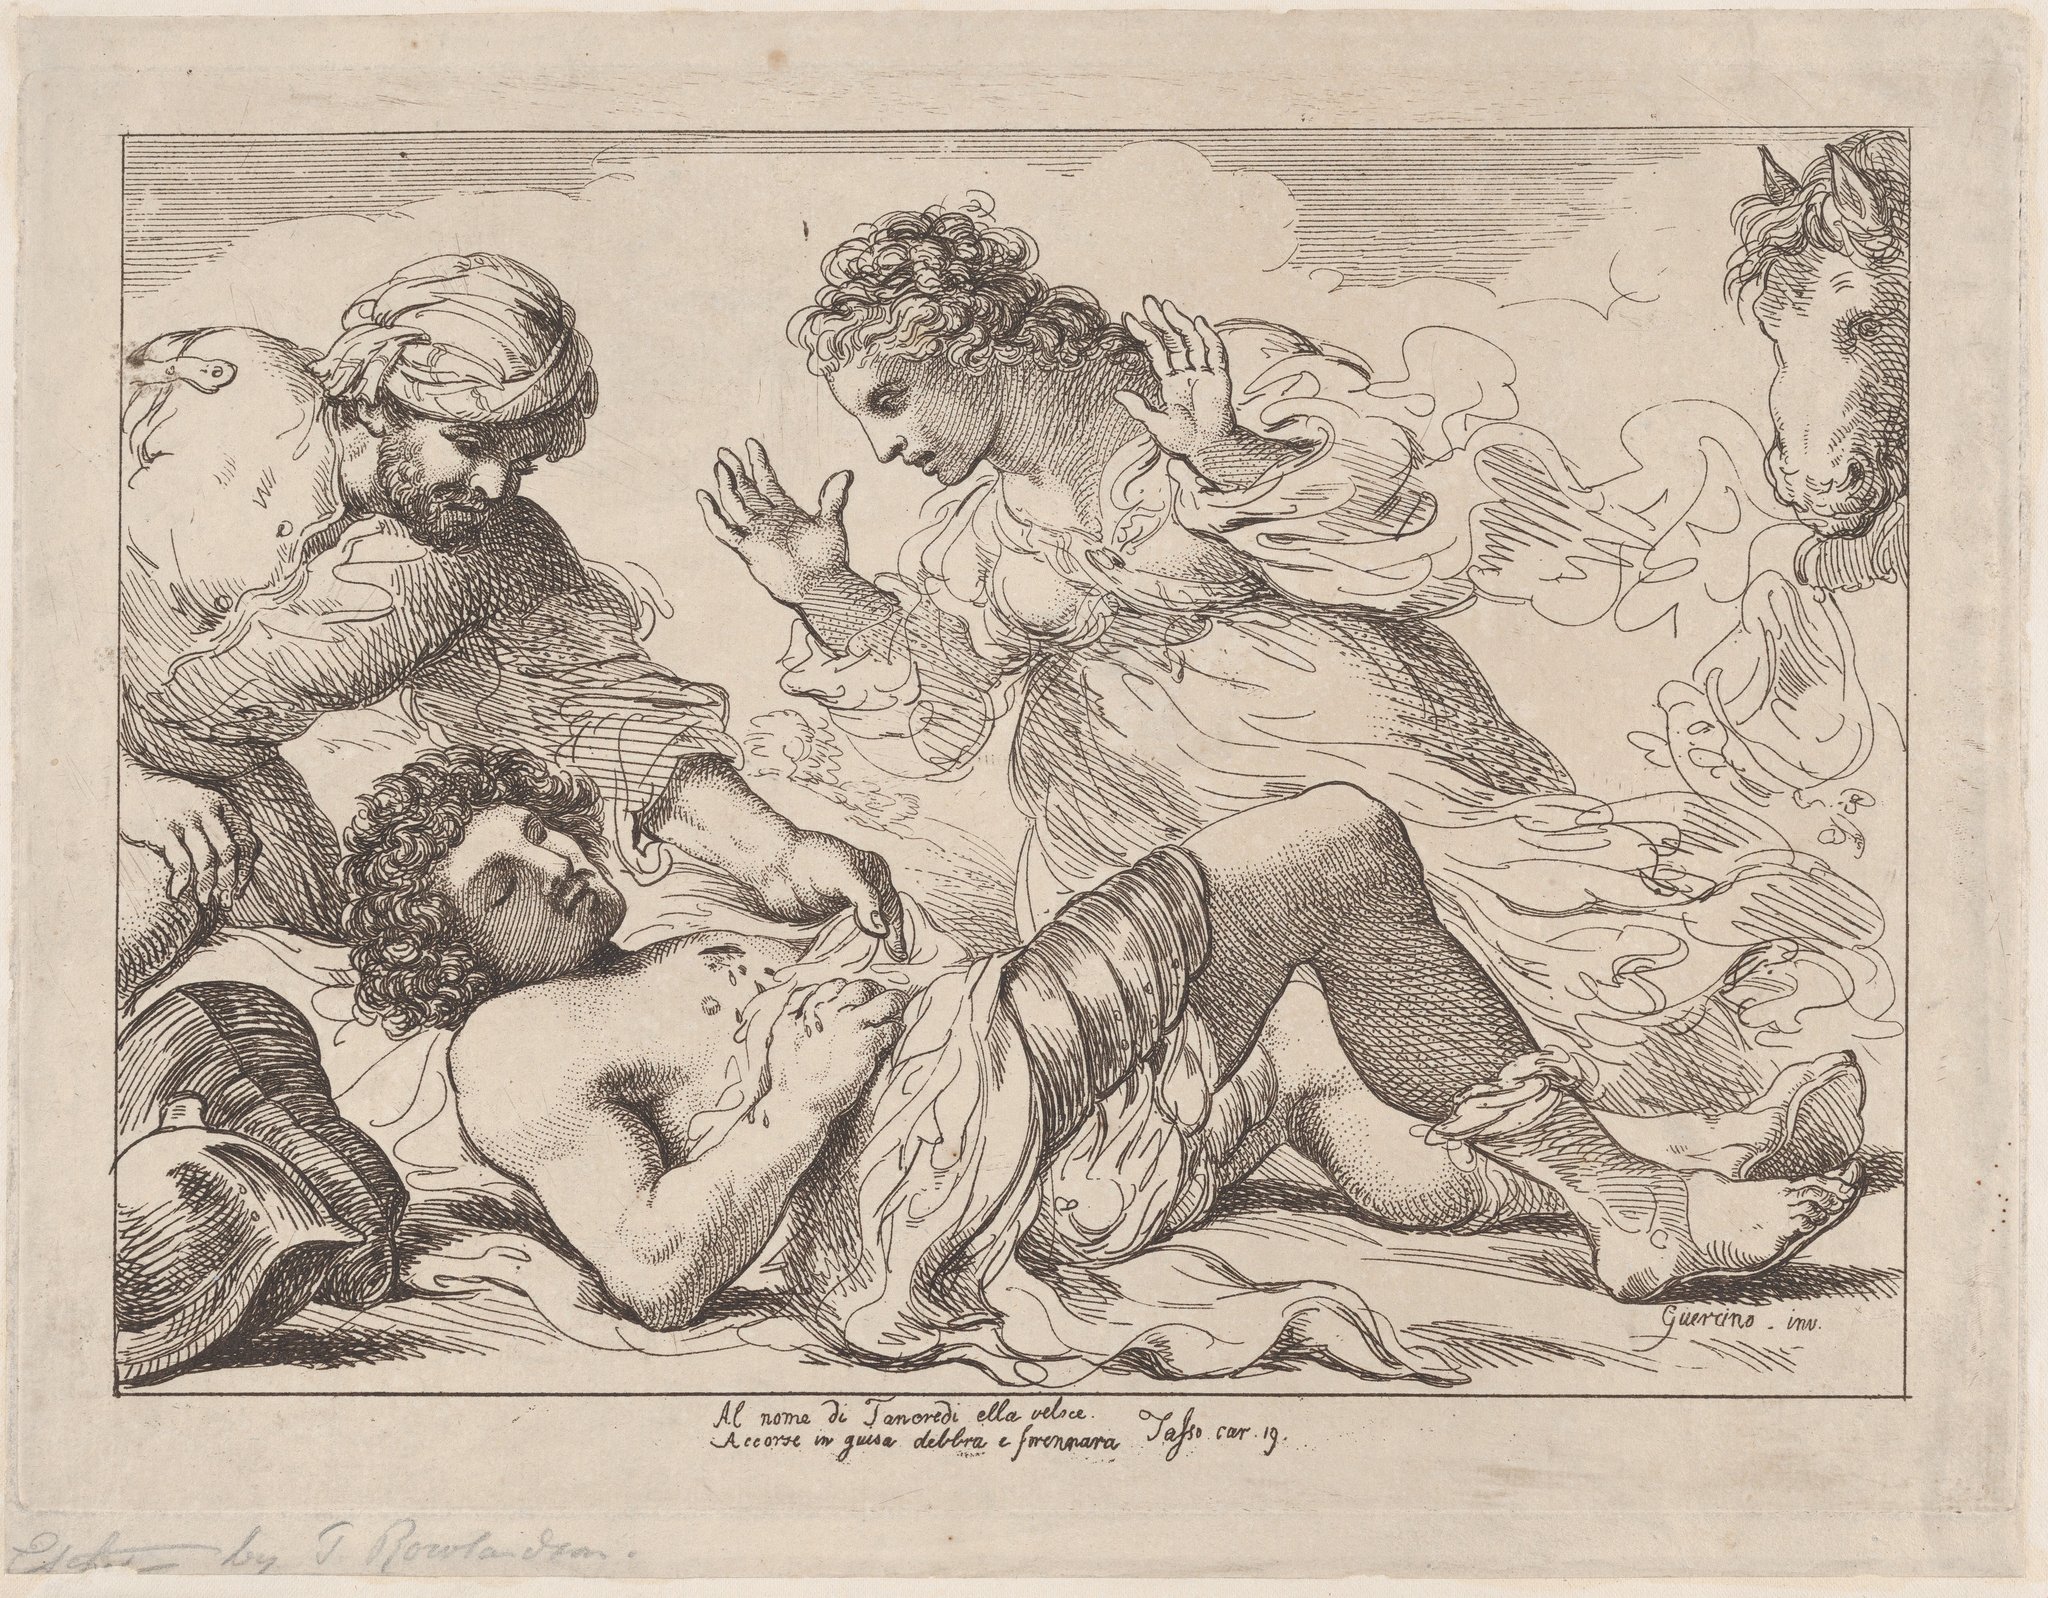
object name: print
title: Erminia Discovers the Wounded Tancred (from Tasso, Gerusalemme Liberata)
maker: thomas rowlandson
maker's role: artist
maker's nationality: british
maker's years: 1757-1827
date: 1790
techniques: etching